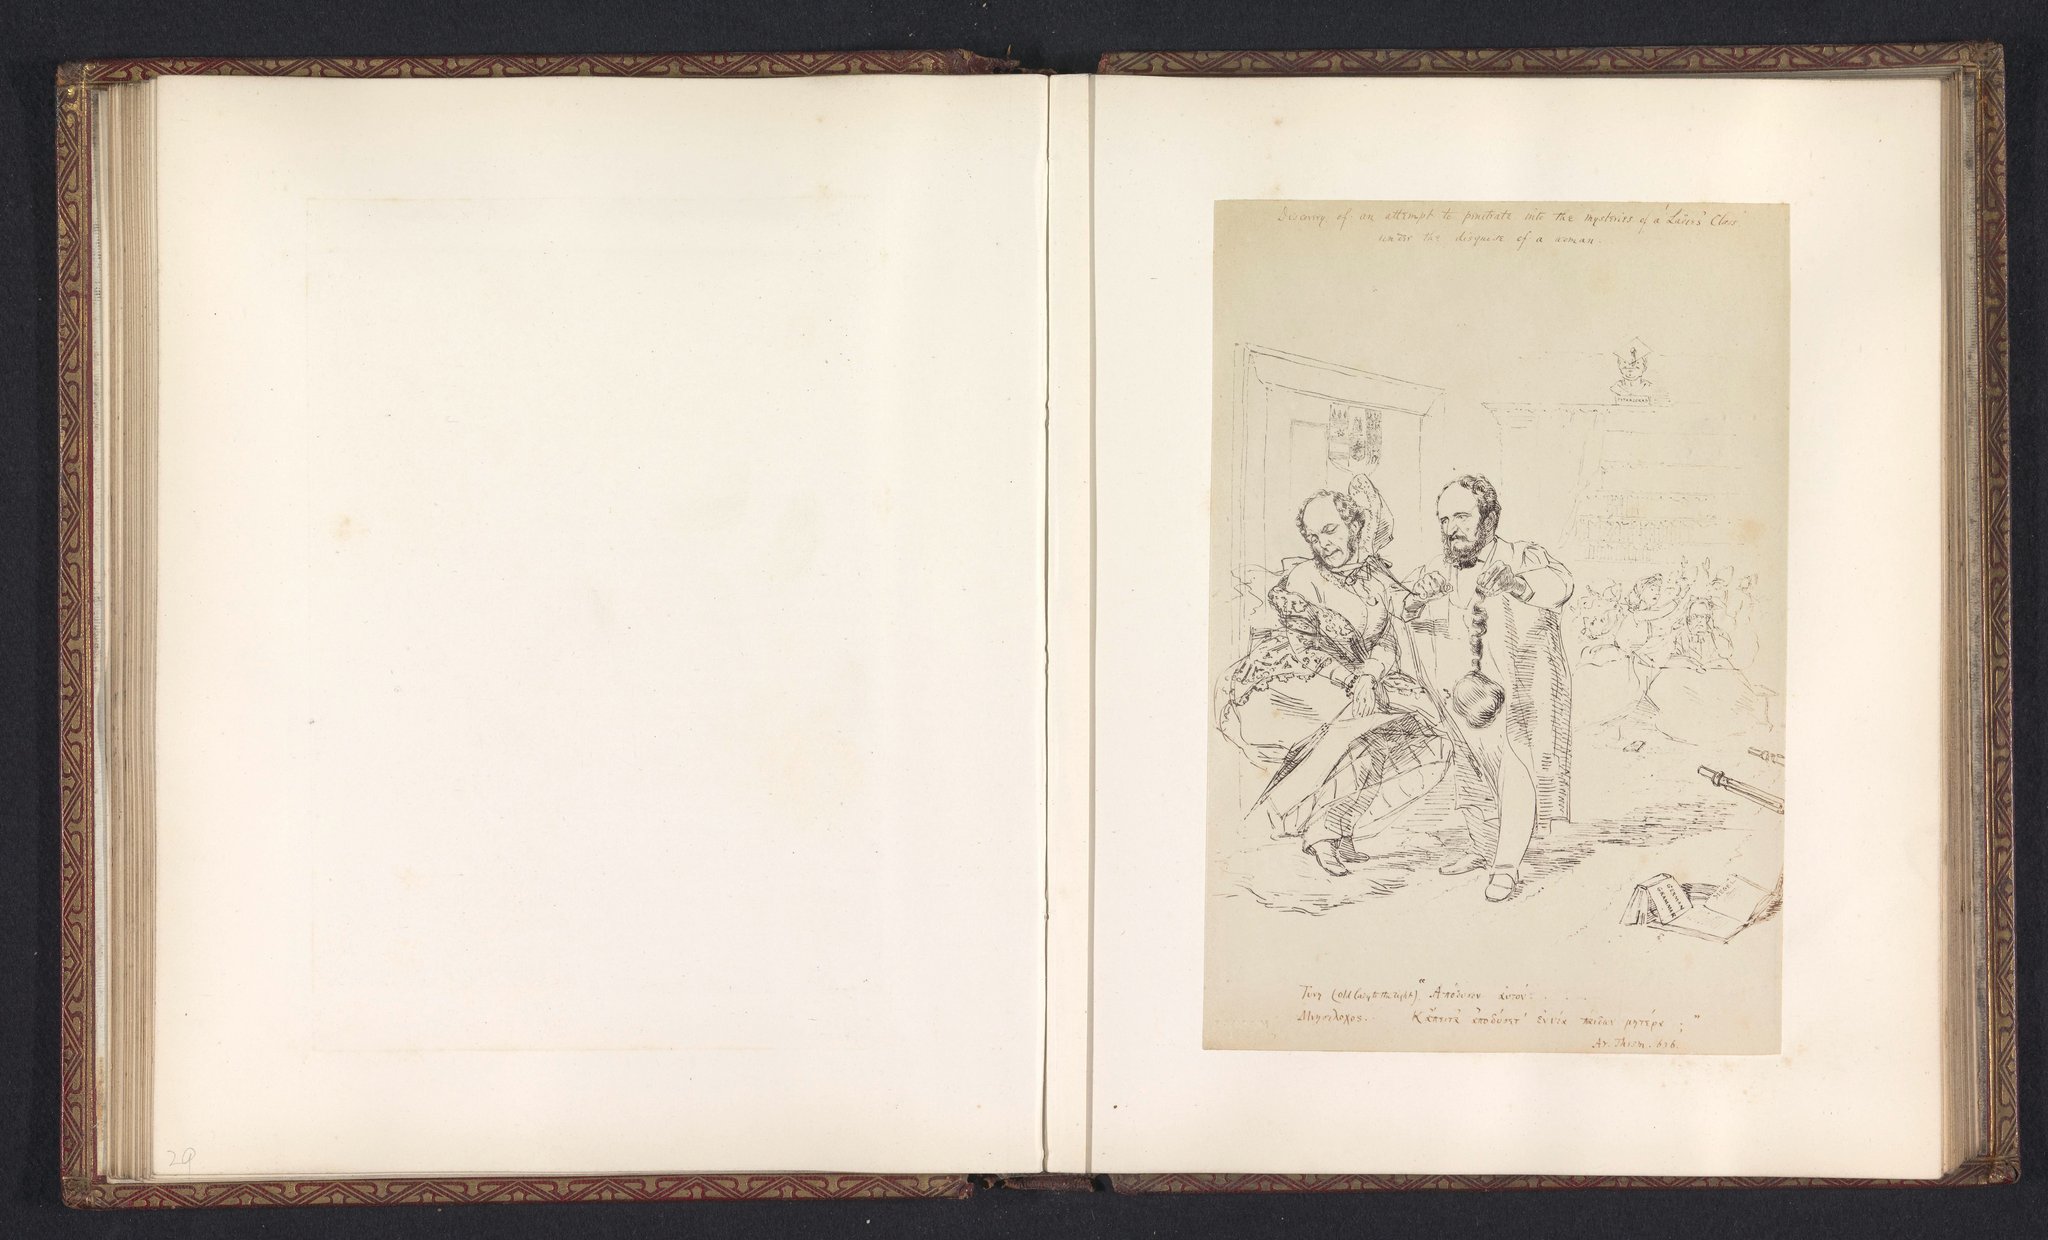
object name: page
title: Fotoreproductie van een tekening, voorstellende de rector van Lincoln ontdekt de aanwezigheid van eerwaarde T. H. Sheppard, verkleed als een vrouw, tijdens een klas voor vrouwen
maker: Anonymous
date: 1855-1866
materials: photographic support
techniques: albumen print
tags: man dressed as woman, travesty, lecture ~ university, caricatures (human types), student life